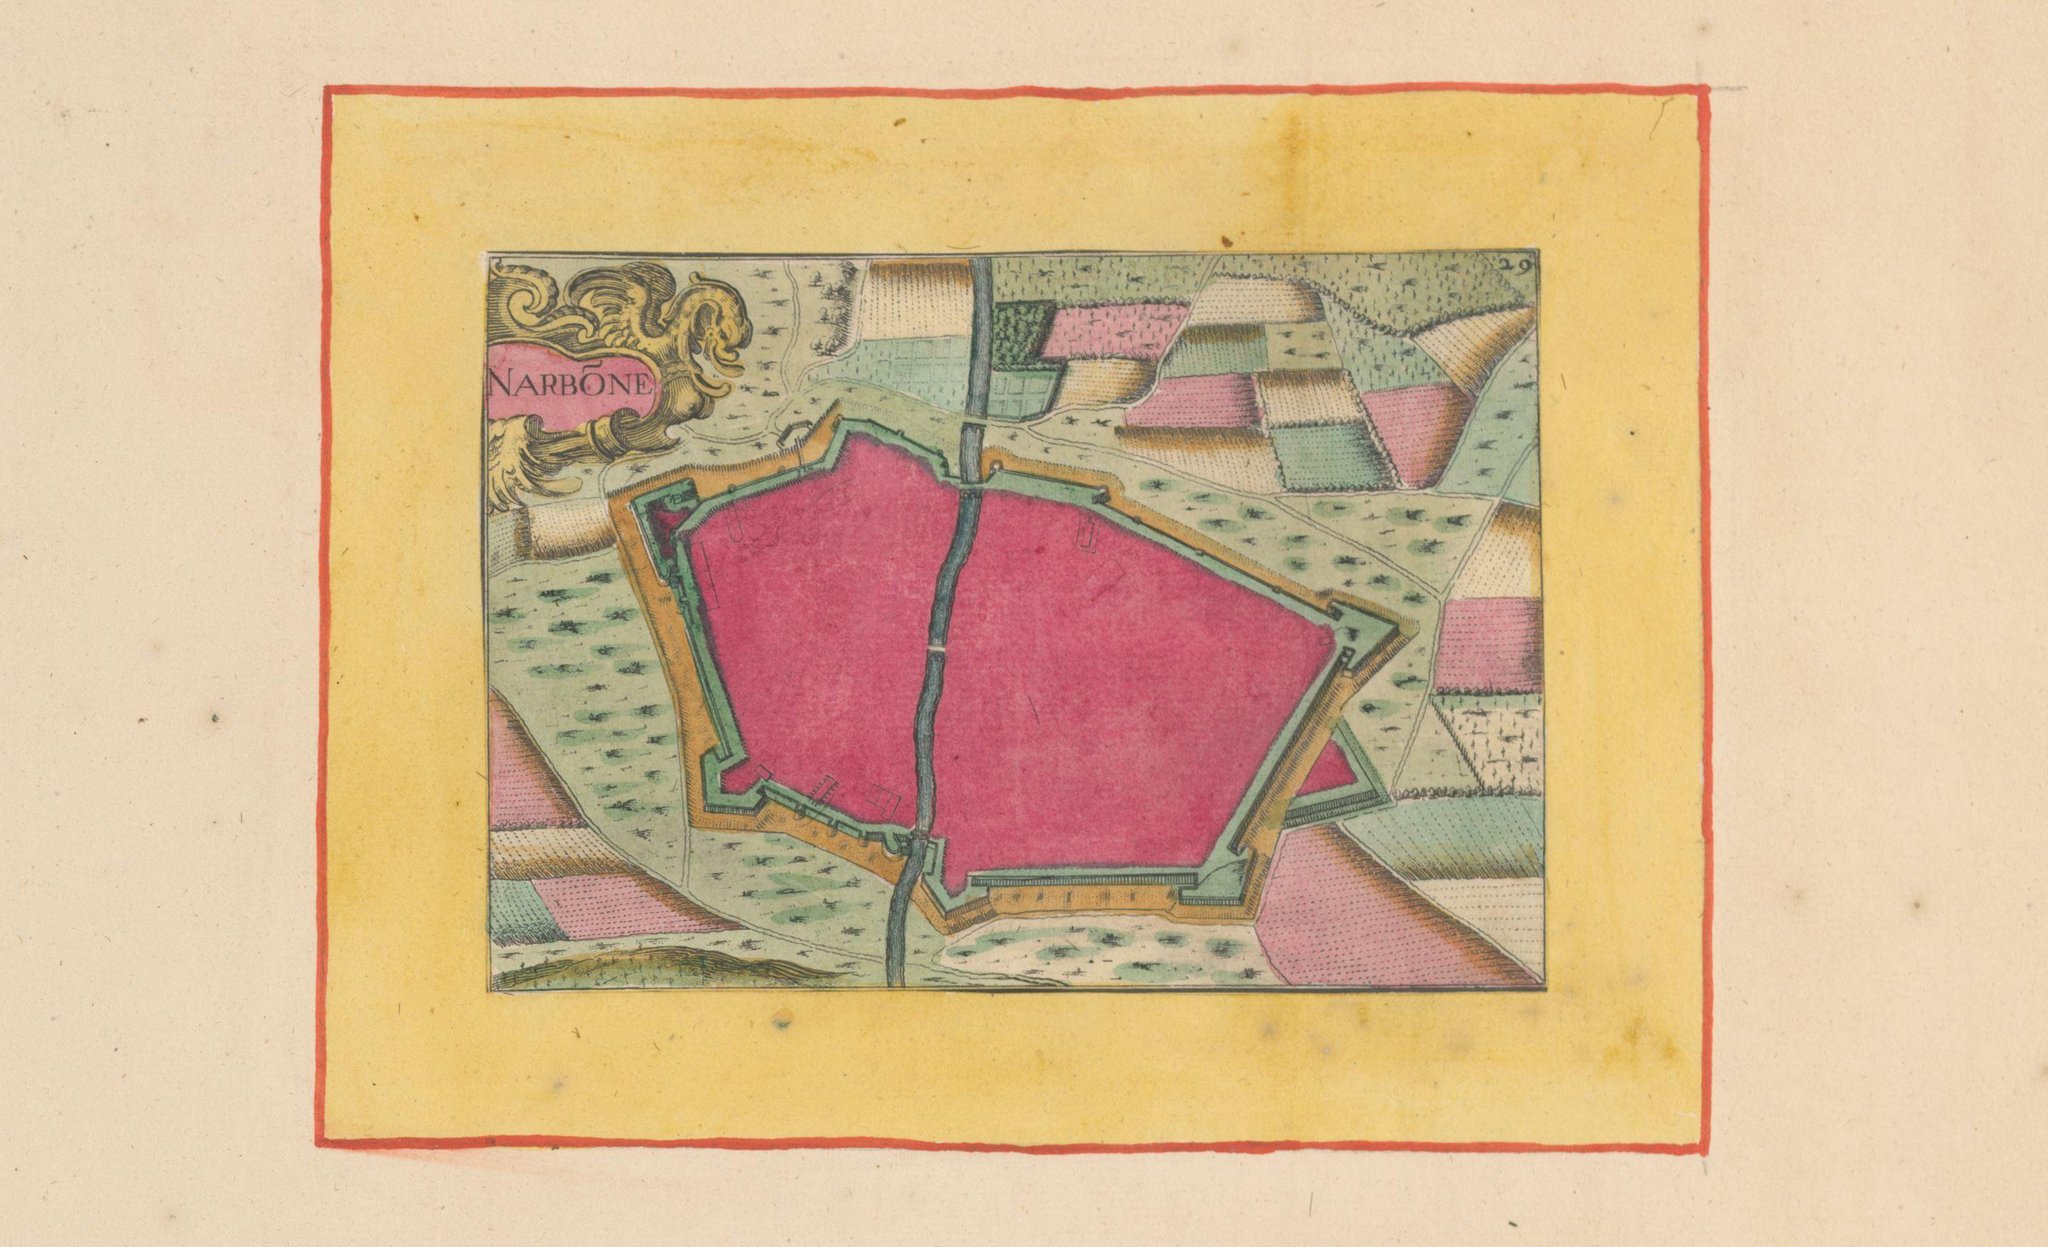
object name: album leaf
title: Vestingplattegrond van Narbonne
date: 1638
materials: paper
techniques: engraving, etching, hand coloring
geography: the hague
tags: maps of cities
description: Prent uit: Tassin, Christophe. Les plans et profils de toutes les principales villes et lieux considérables de France (...). Parijs: Michel van Lochom, 1638, prent nummer 29 in het deel 'Languedoc'.